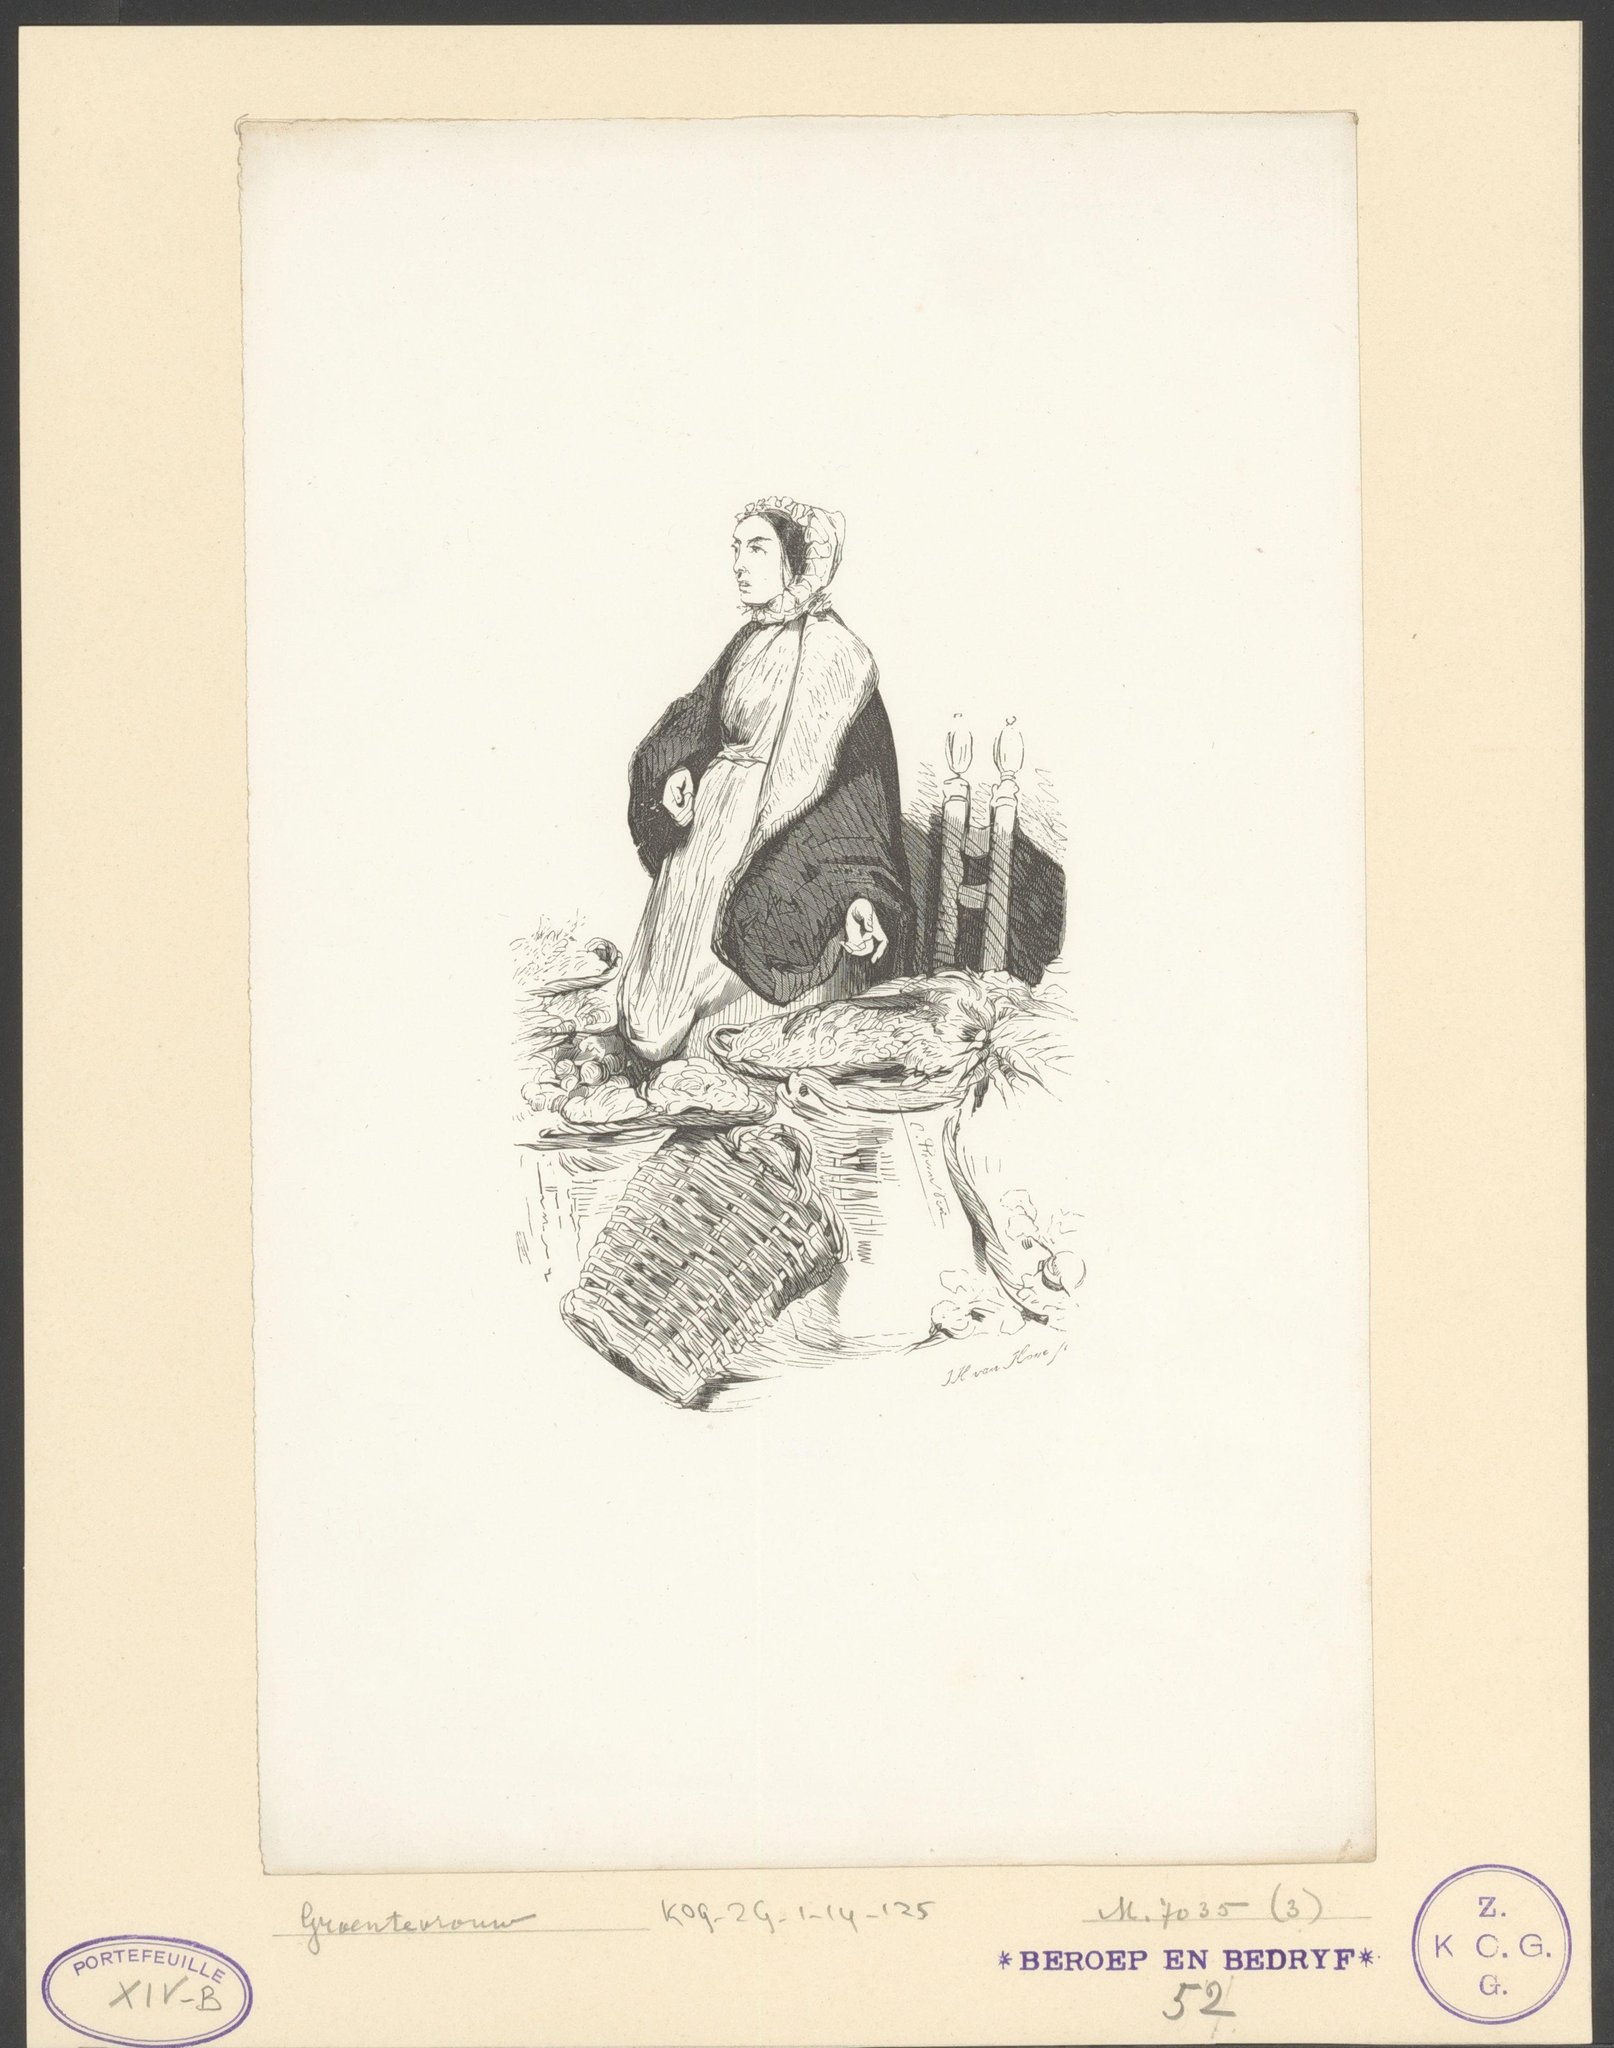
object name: print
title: Groentevrouw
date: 1841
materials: paper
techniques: engraving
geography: the hague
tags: vegetables, merchant, salesman - bb - women engaged in trade and commerce, selling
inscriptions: collector's mark, collector's mark: Lugt 1641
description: Illustratie gemaakt voor het boek 'De Nederlanden : karakterschetsen, kleederdrachten, houding en voorkomen van verschillende standen : tekst van de meest geachte schrijvers : met gravuren van Henry Brown naar teekeningen van de voornaamste Nederlandsche kunstenaars, Den Haag, 1841.